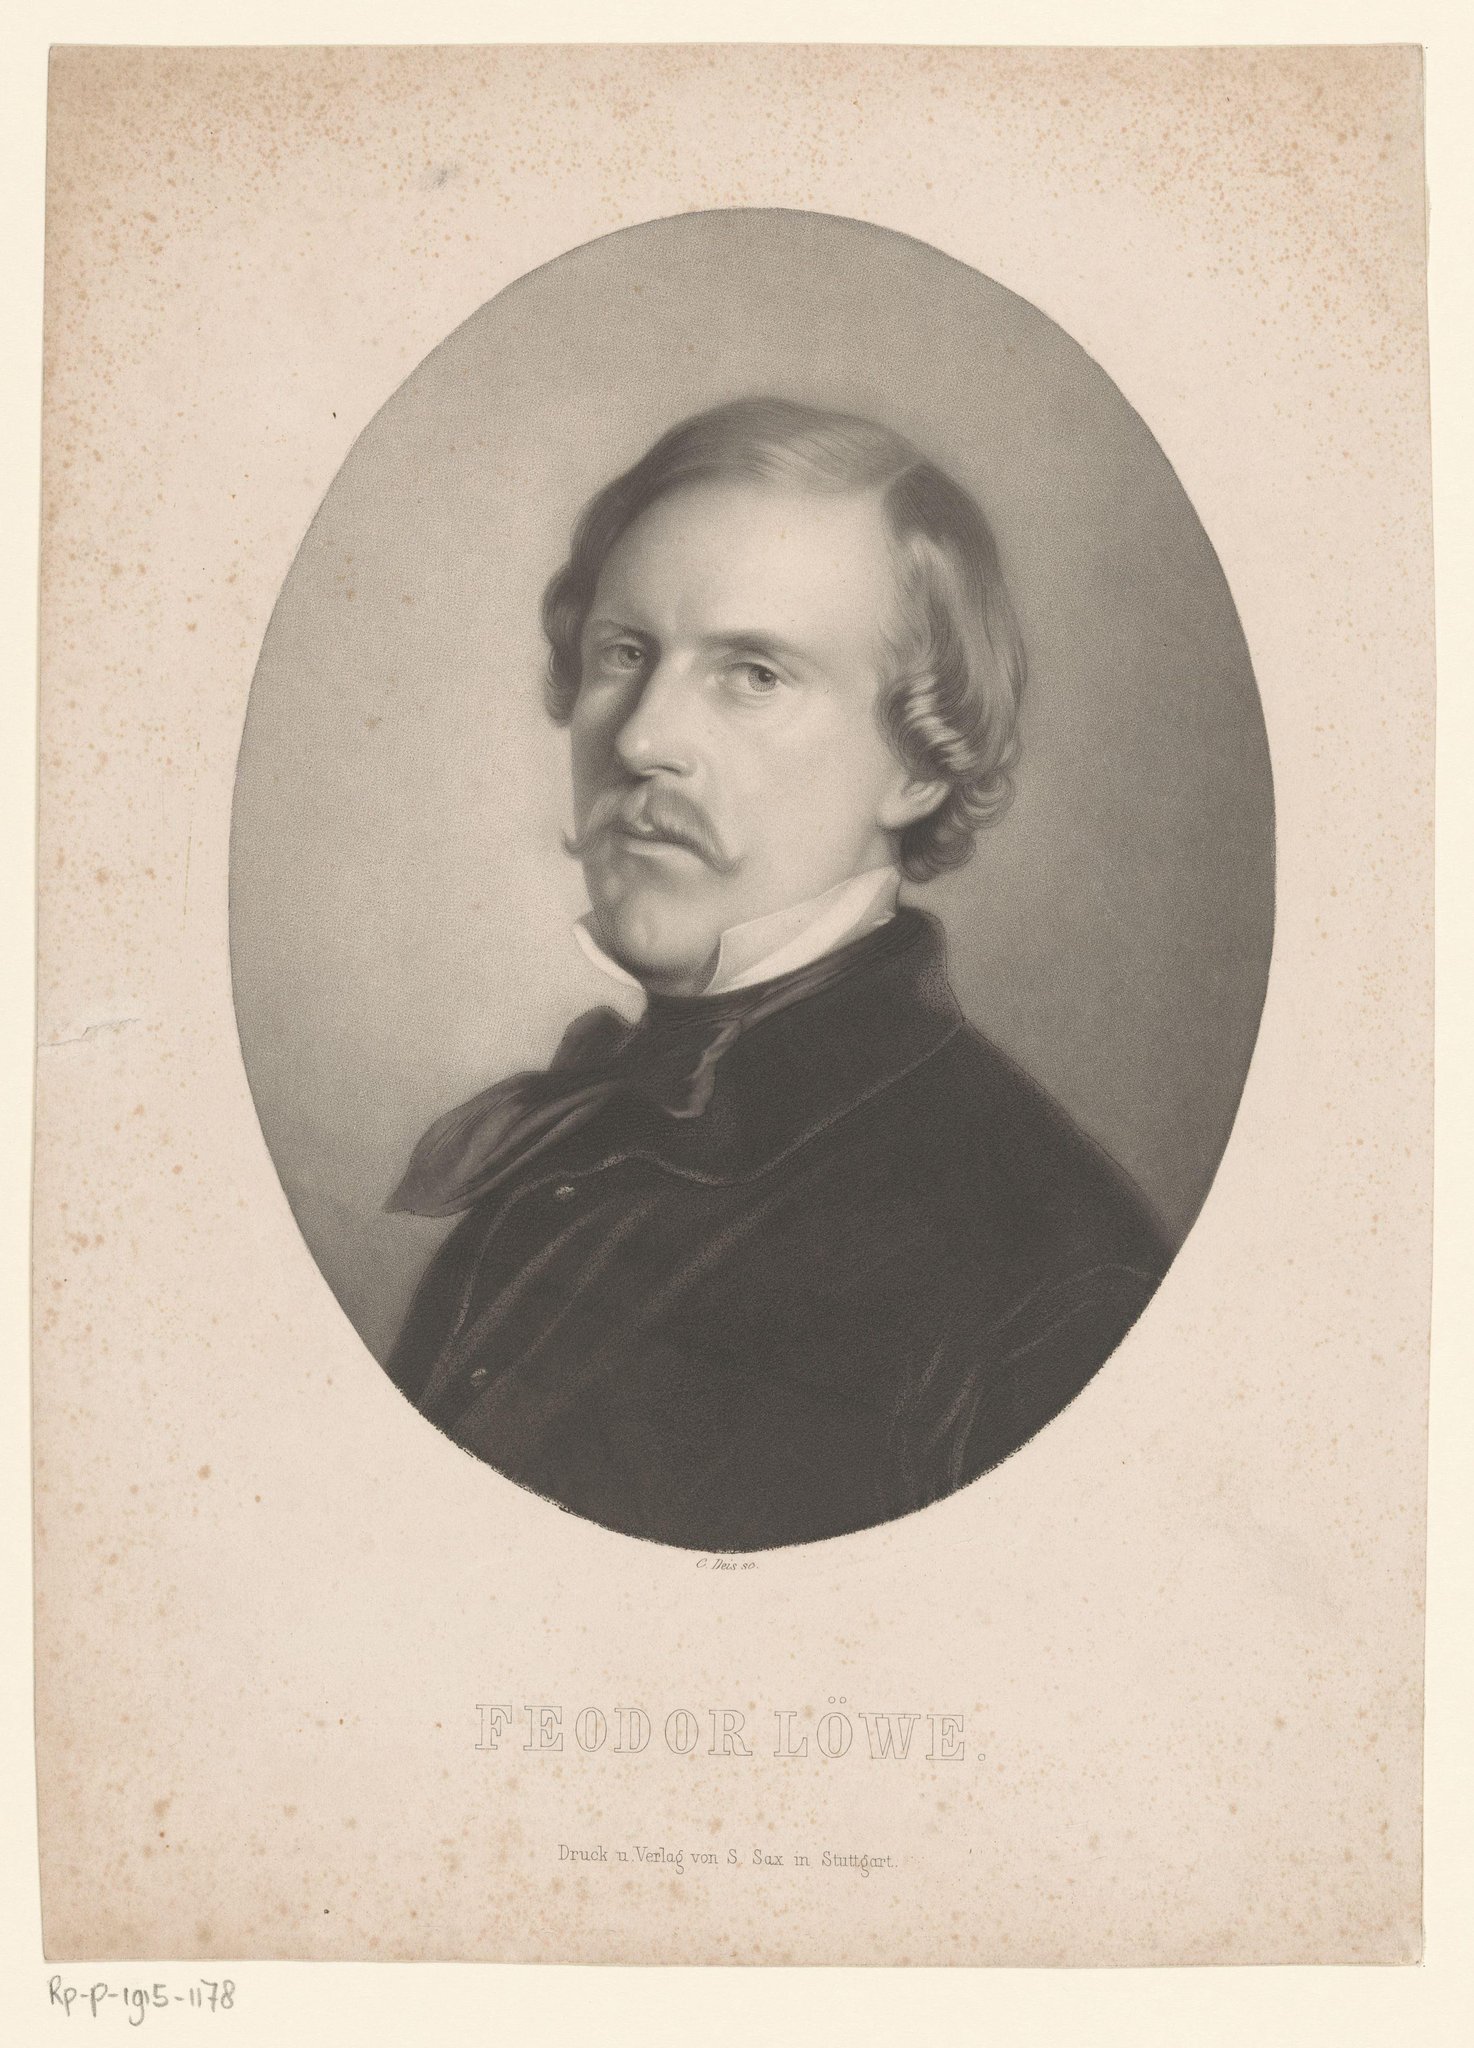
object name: print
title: Portret van Franz Ludwig Feodor Löwe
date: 1826-1884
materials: paper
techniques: mezzotint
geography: stuttgart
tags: historical persons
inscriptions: collector's mark: Lugt 2228